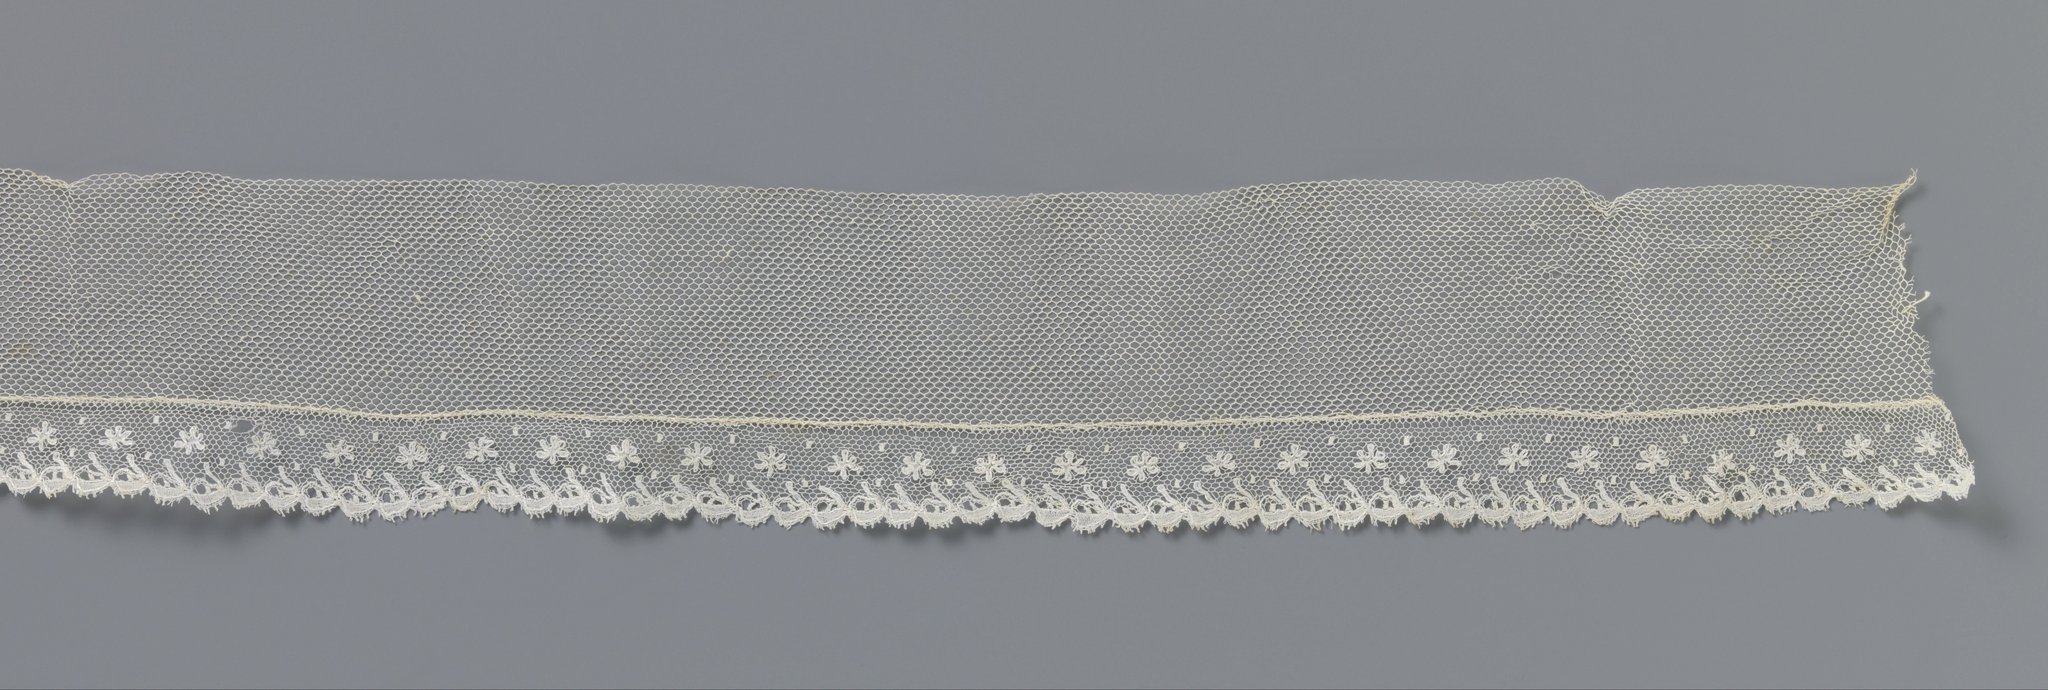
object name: strip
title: Strook machinale tule met daaraan een strook kloskant met rozetjes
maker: Anonymous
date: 1840-1849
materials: linen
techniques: lace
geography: lille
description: Strook machinale tule waaraan een smallere strook is genaaid van naturelkleurige kloskant: Rijselse kant. Het patroon bestaat uit een rij rozetjes op de middenlijn, afgewisseld door twee boven elkaar geplaatste vierkante moesjes. De schulpjes langs de onderzijde worden gevormd door aaneengeschakelde ovaaltjes, waartussen steeds één schuingeplaatst en eenzijdig gericht steeltje steekt. De spaarzame motieven zijn met elkaar verbonden door een fijne traliegrond, een tulegrond. Het spaarzame volwerk is gemaakt in linnenslag, met dikkere en glimmende contourdraden. De moesjes en het centrum van elk ovaaltje bestaan uit blokjes gemaakt in vormslag. De bovenzijde is recht afgewerkt en de schulpjes langs de onderzijde zijn afgewerkt met picots.